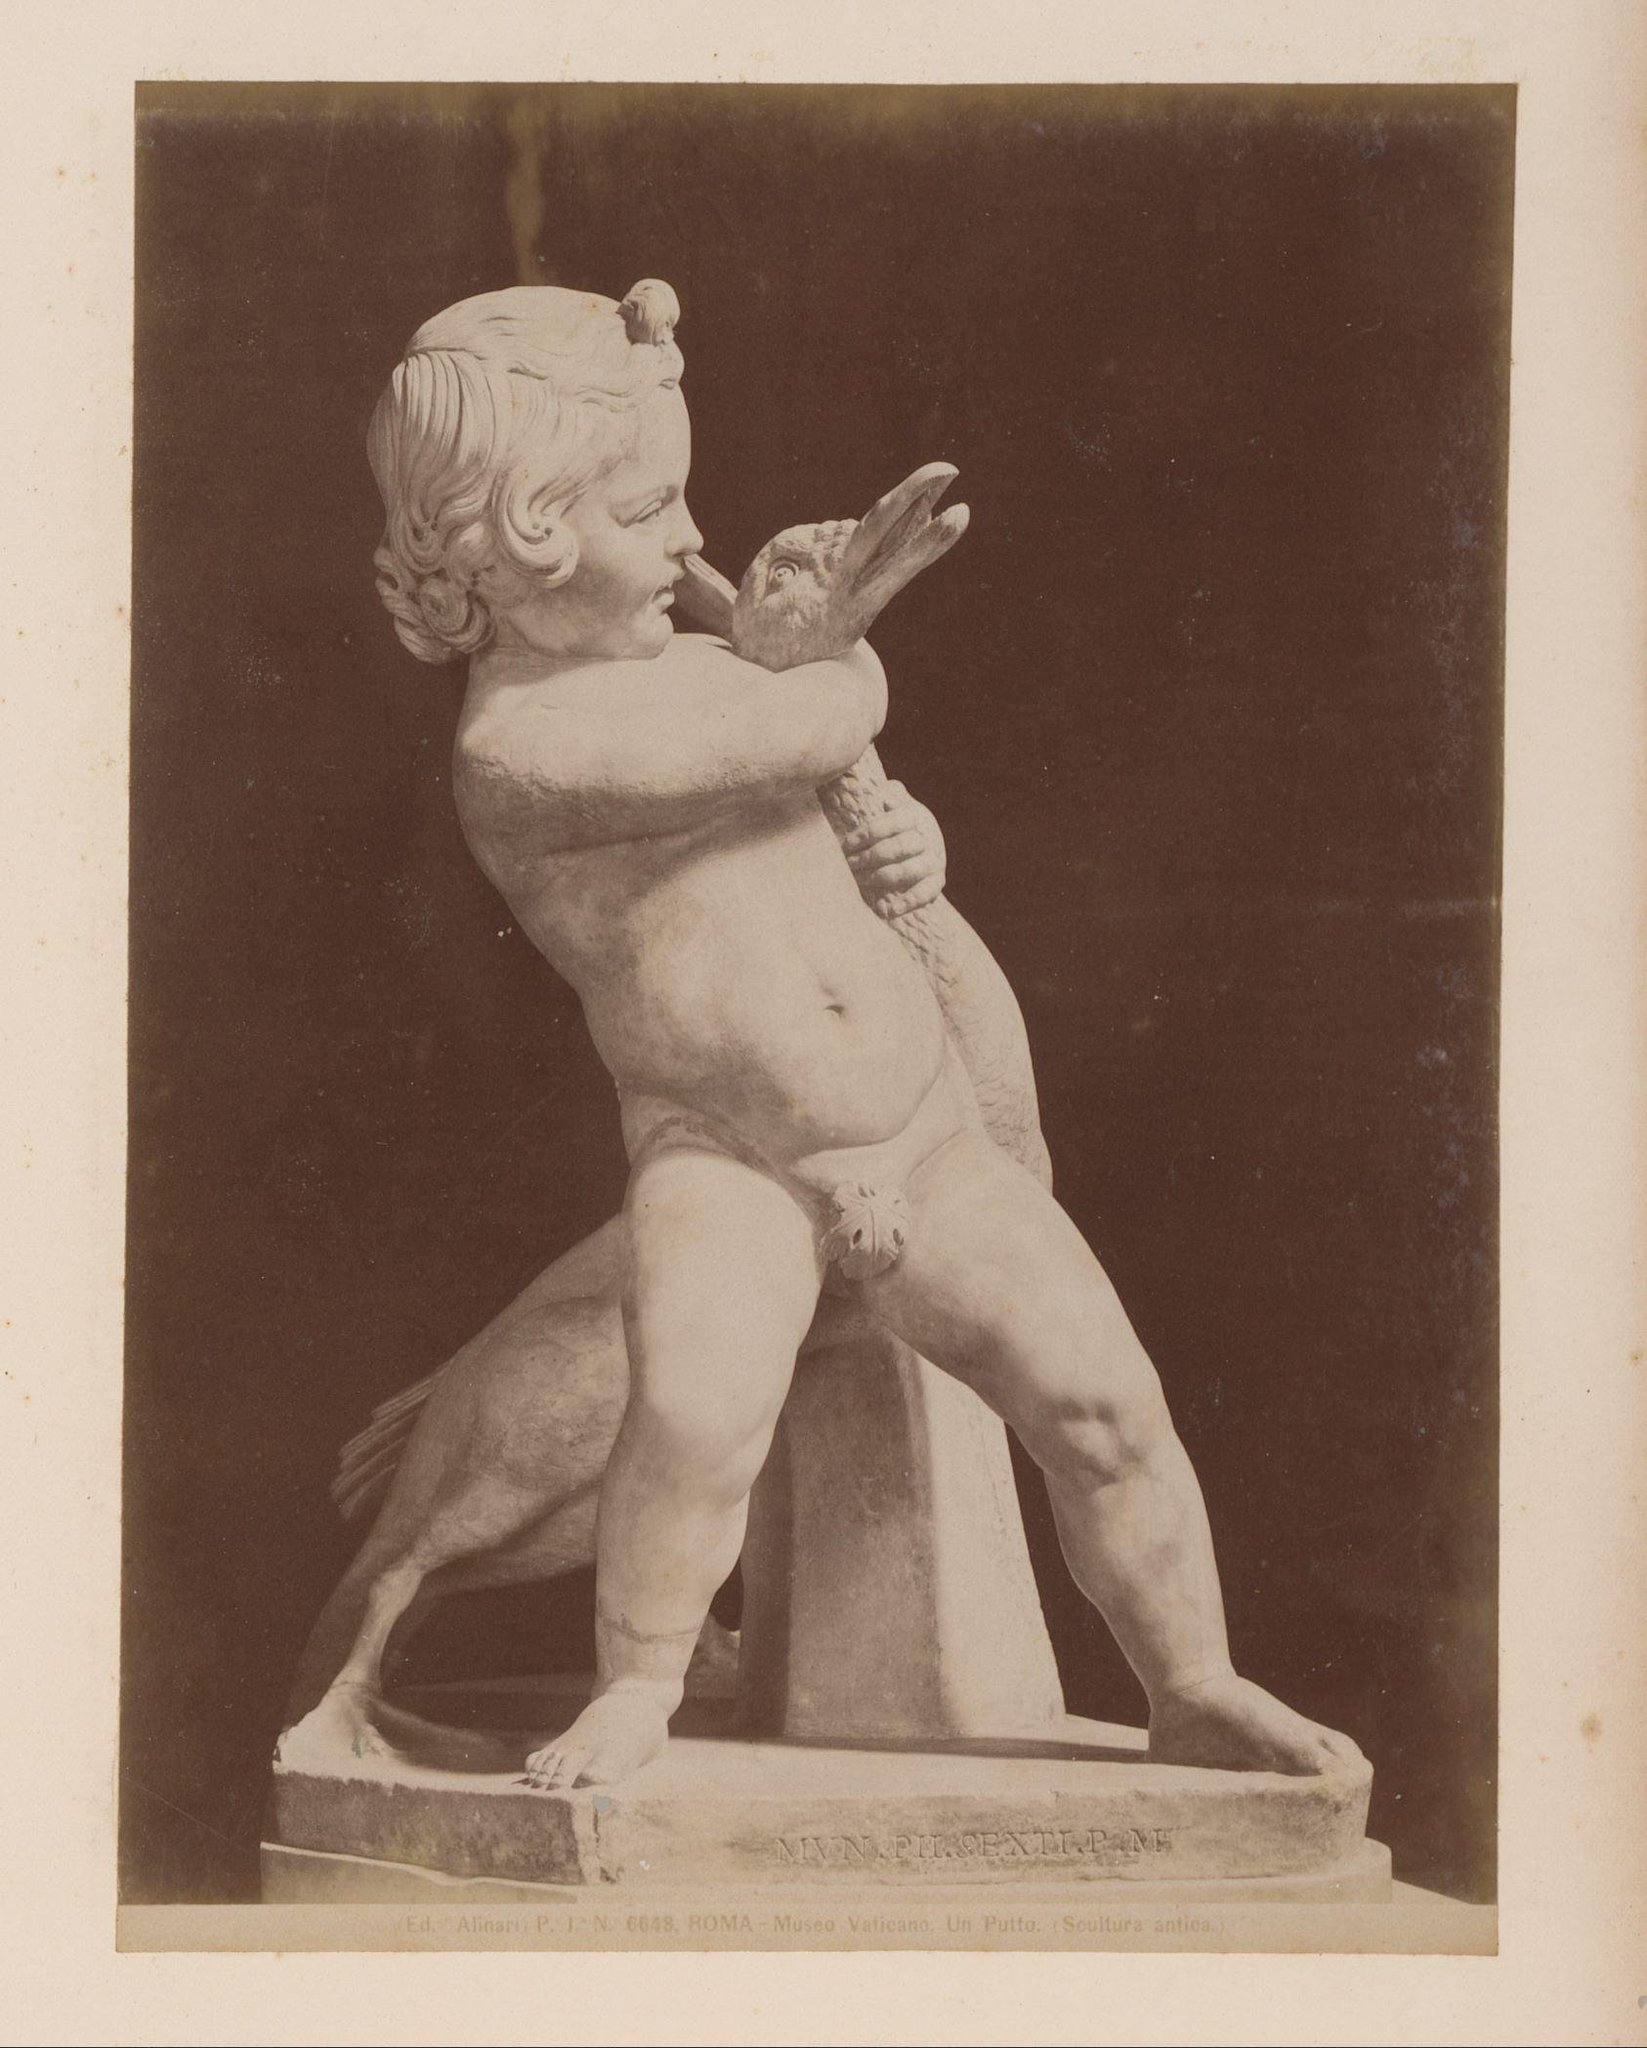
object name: photograph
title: Sculptuur van jongen met gans, Vaticaan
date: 1860-1900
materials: paper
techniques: albumen print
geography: vatican museums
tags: water-birds: goose, piece of sculpture, reproduction of a piece of sculpture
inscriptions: inscription: ‘(Ed.ne Alinari) P.e 2.a N. 6648. ROMA - Museo Vaticano. Un Putto. (Scultura antica.)’